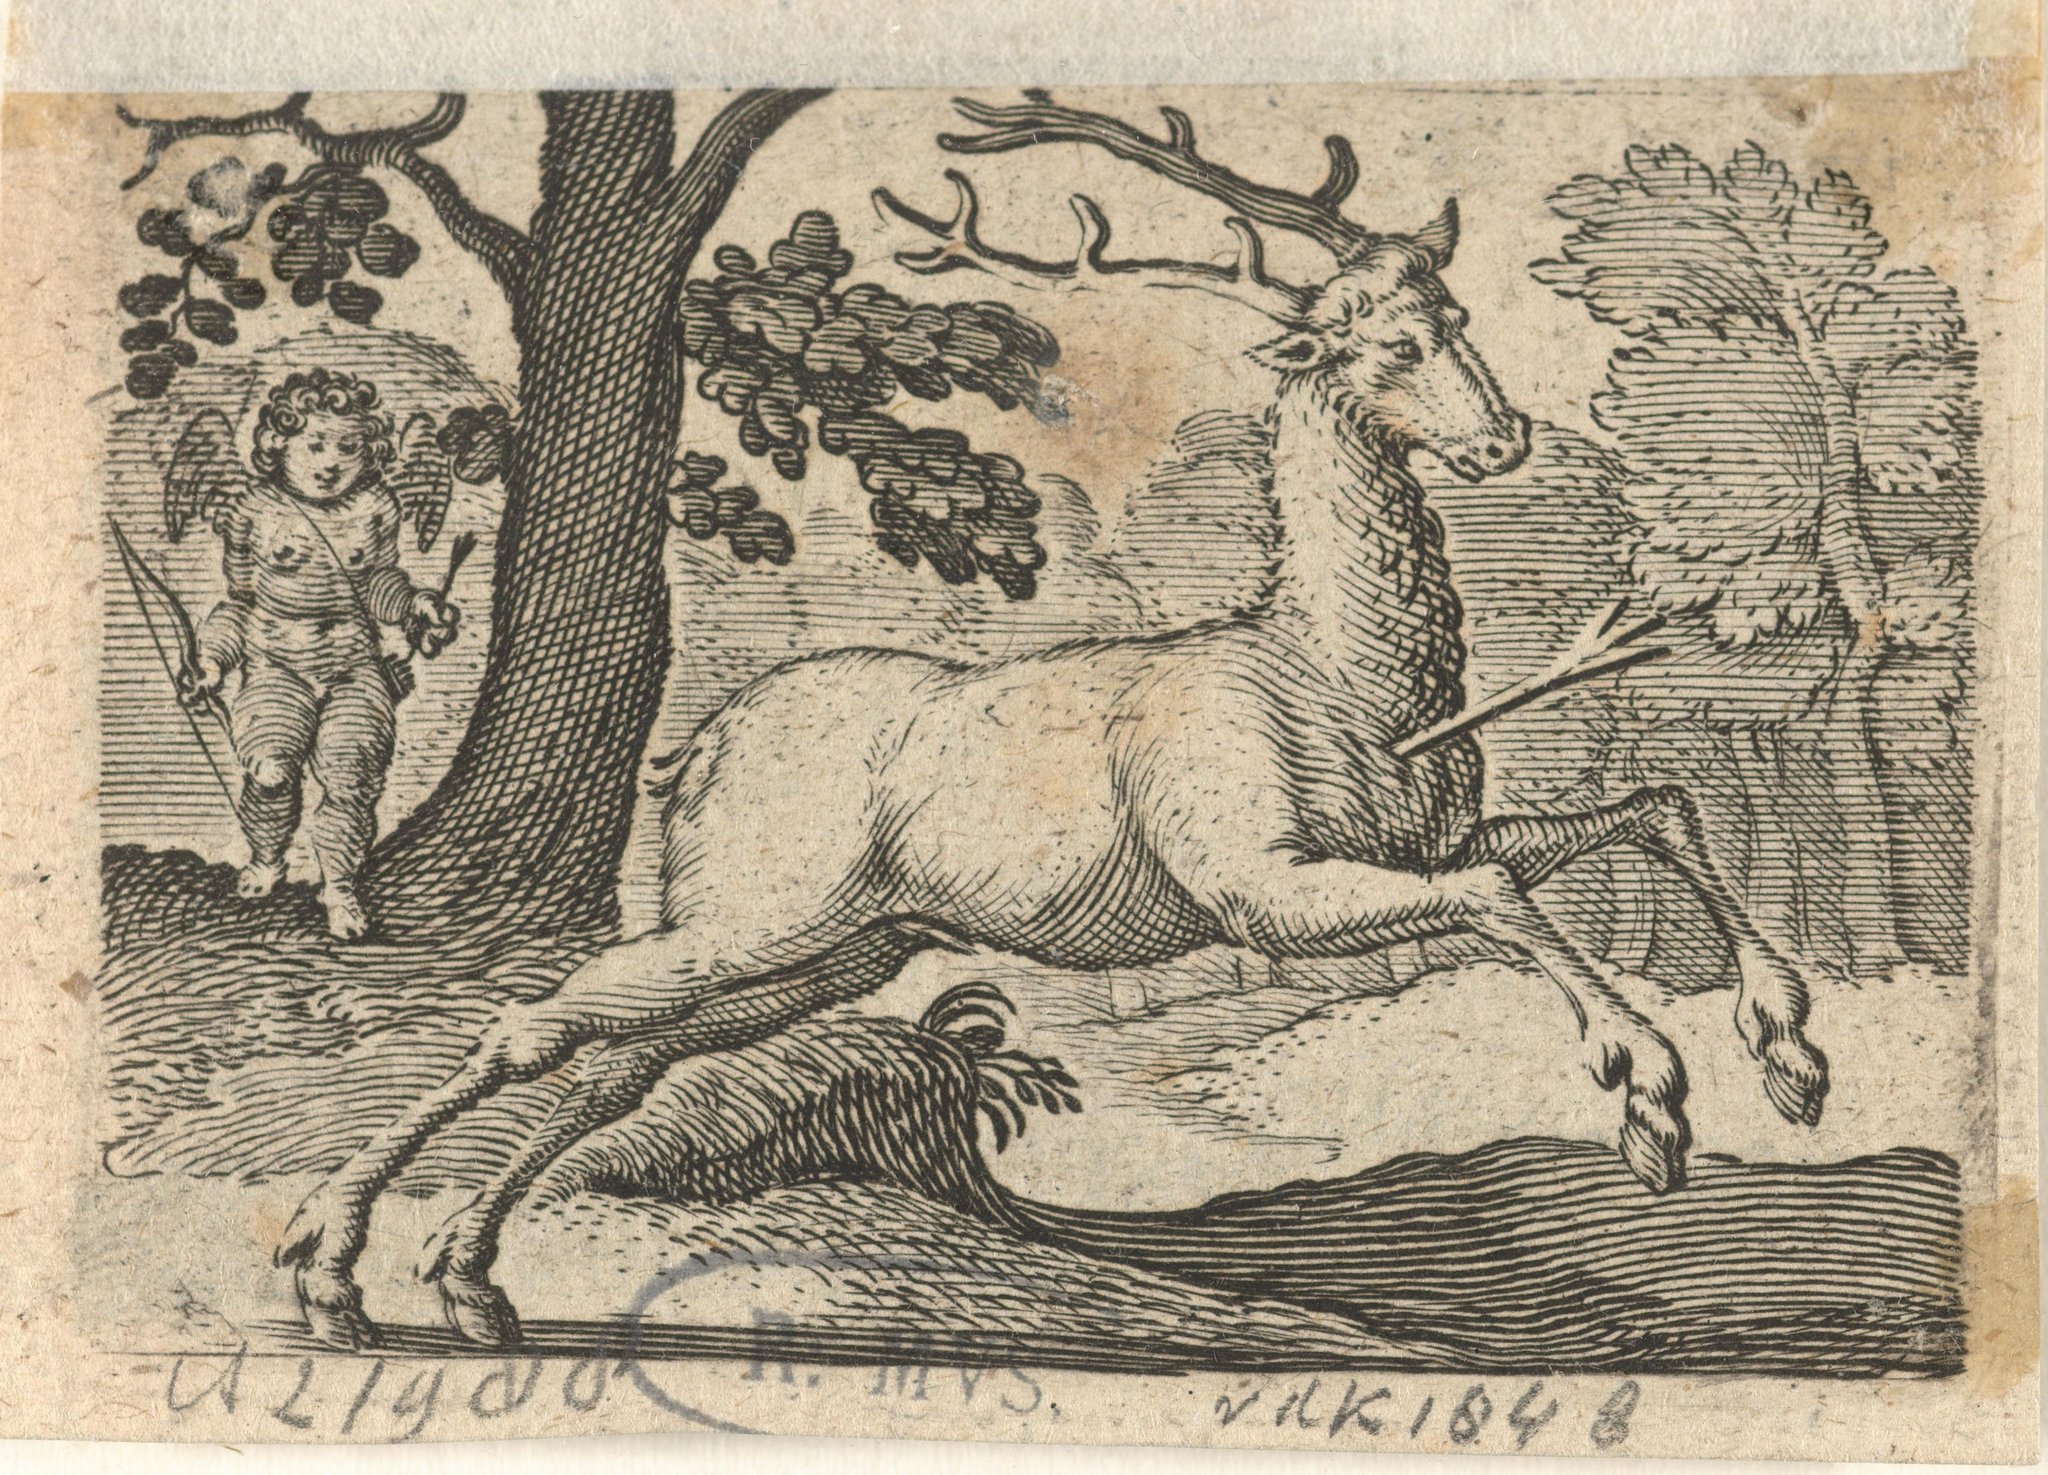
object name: print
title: Liefdesemblemen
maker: michiel le blon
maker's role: print maker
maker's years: 1587-1656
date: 1616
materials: paper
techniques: engraving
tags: animals (+ animal(s) being wounded), hoofed animals: deer, (story of) cupid, amor (eros)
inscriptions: collector's mark: Lugt 2228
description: Een hert rent door een landschap met een pijl in zijn borst. Links kijk Amor met zijn pijl en boog vanonder een boom toe. De prent maakt deel uit van een serie prenten met liefdesemblemen.